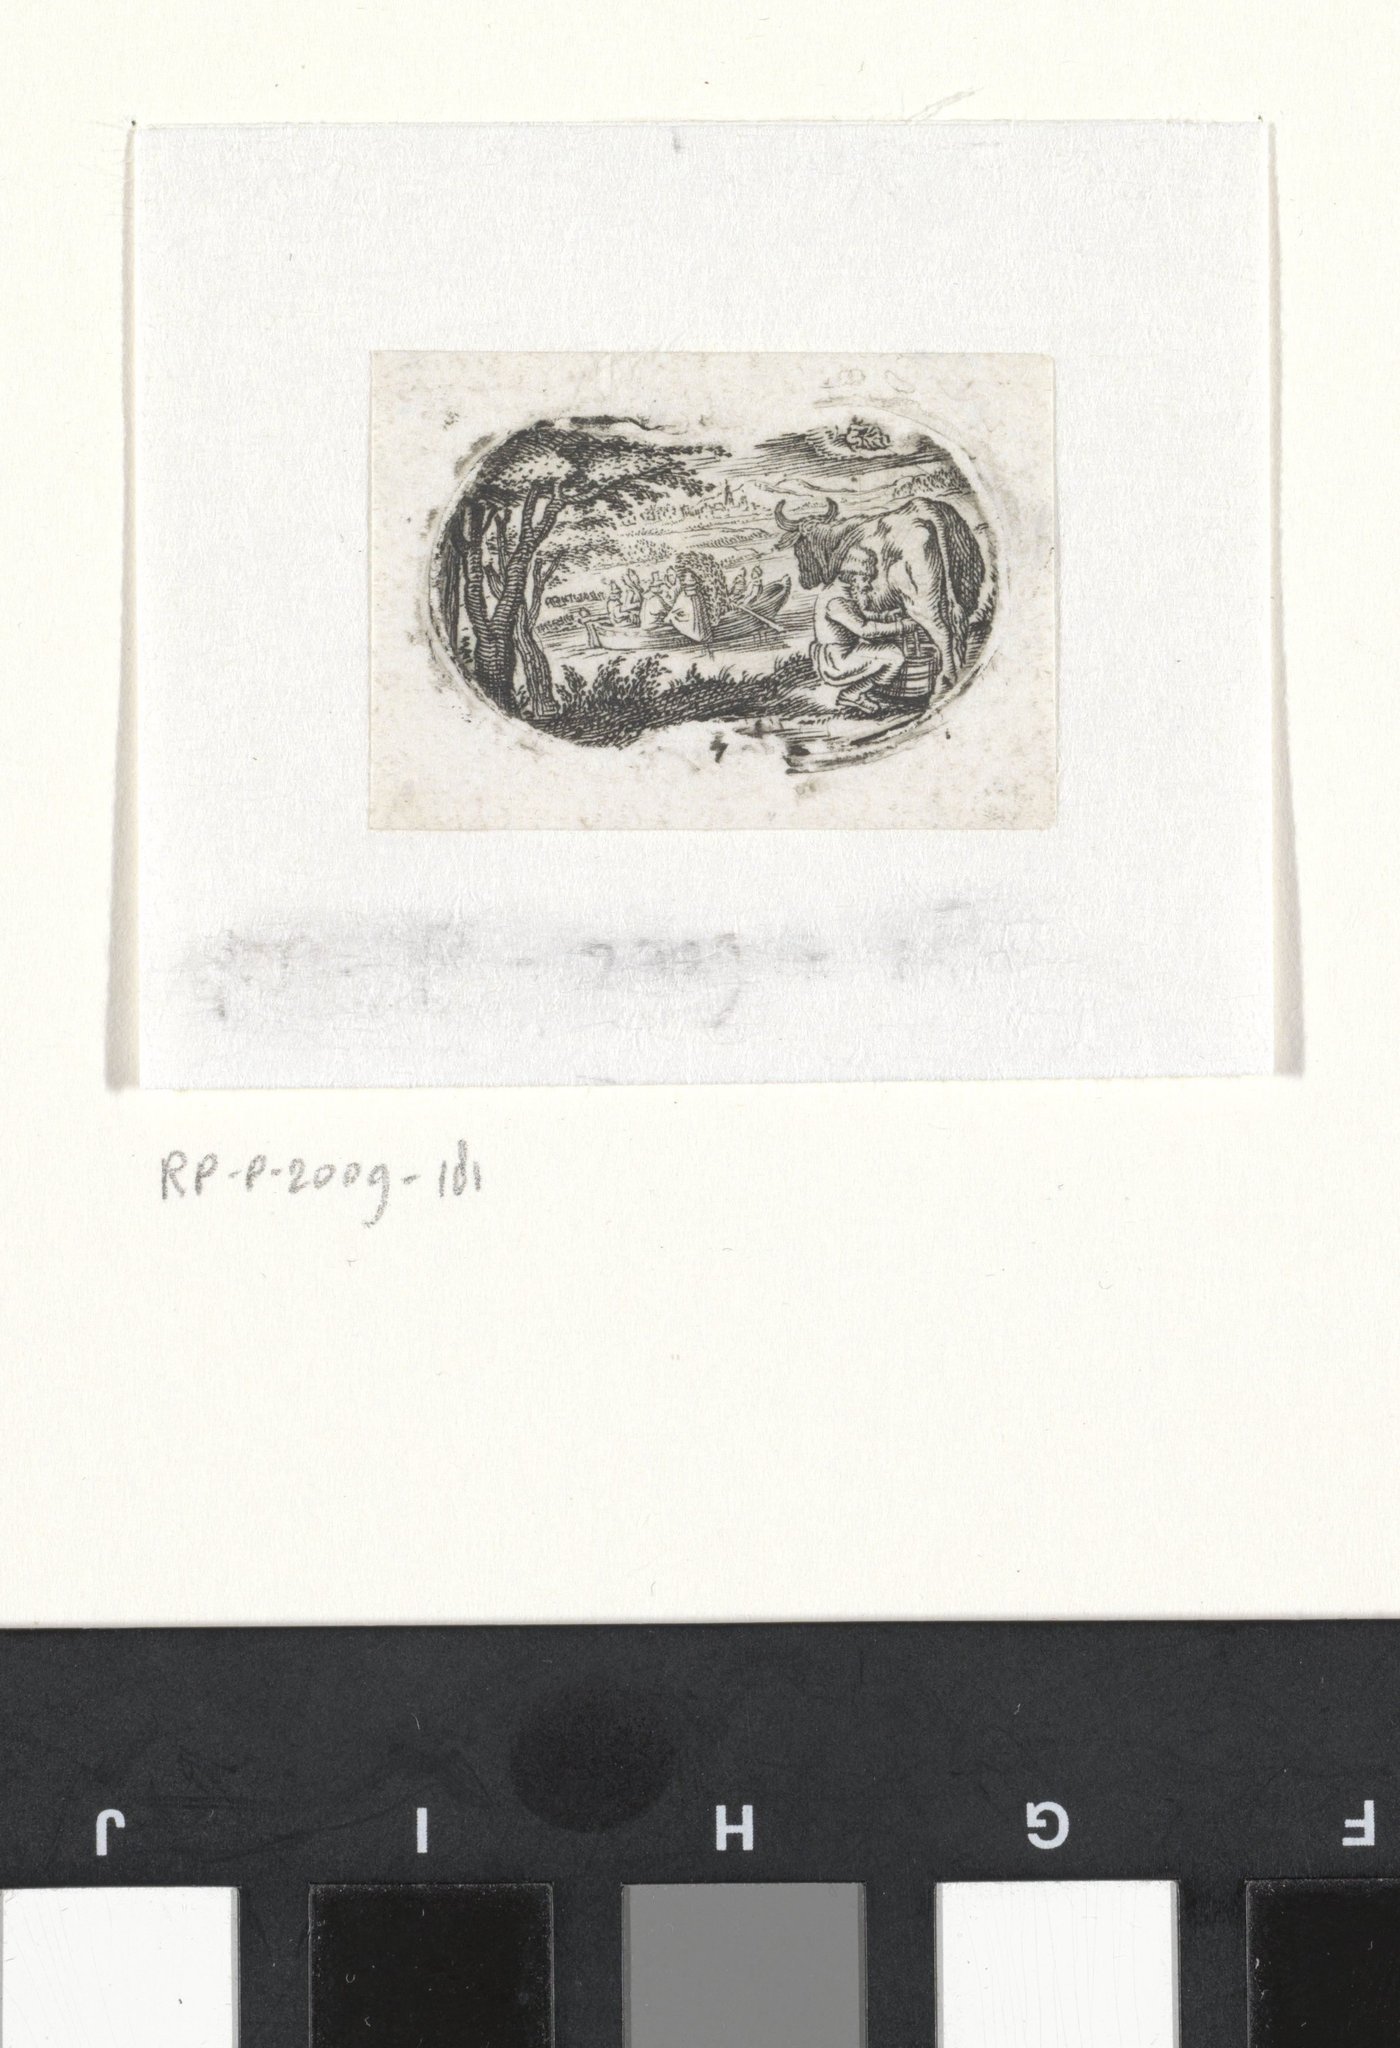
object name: print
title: De twaalf maanden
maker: Anonymous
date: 1625-1700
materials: paper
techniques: engraving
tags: may and its 'labours', spading ~ soil cultivation, gemini (zodiacal sign of may), milking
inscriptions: collector's mark: Lugt 2760, collector's mark: Lugt 2228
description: Menselijke bezigheden in de maand mei. Op de voorgrond een boer die een koe melkt. Op de achtergrond een landschap met rivier en spelevarend gezelschap. Rechtsboven het sterrenbeeld Tweelingen.